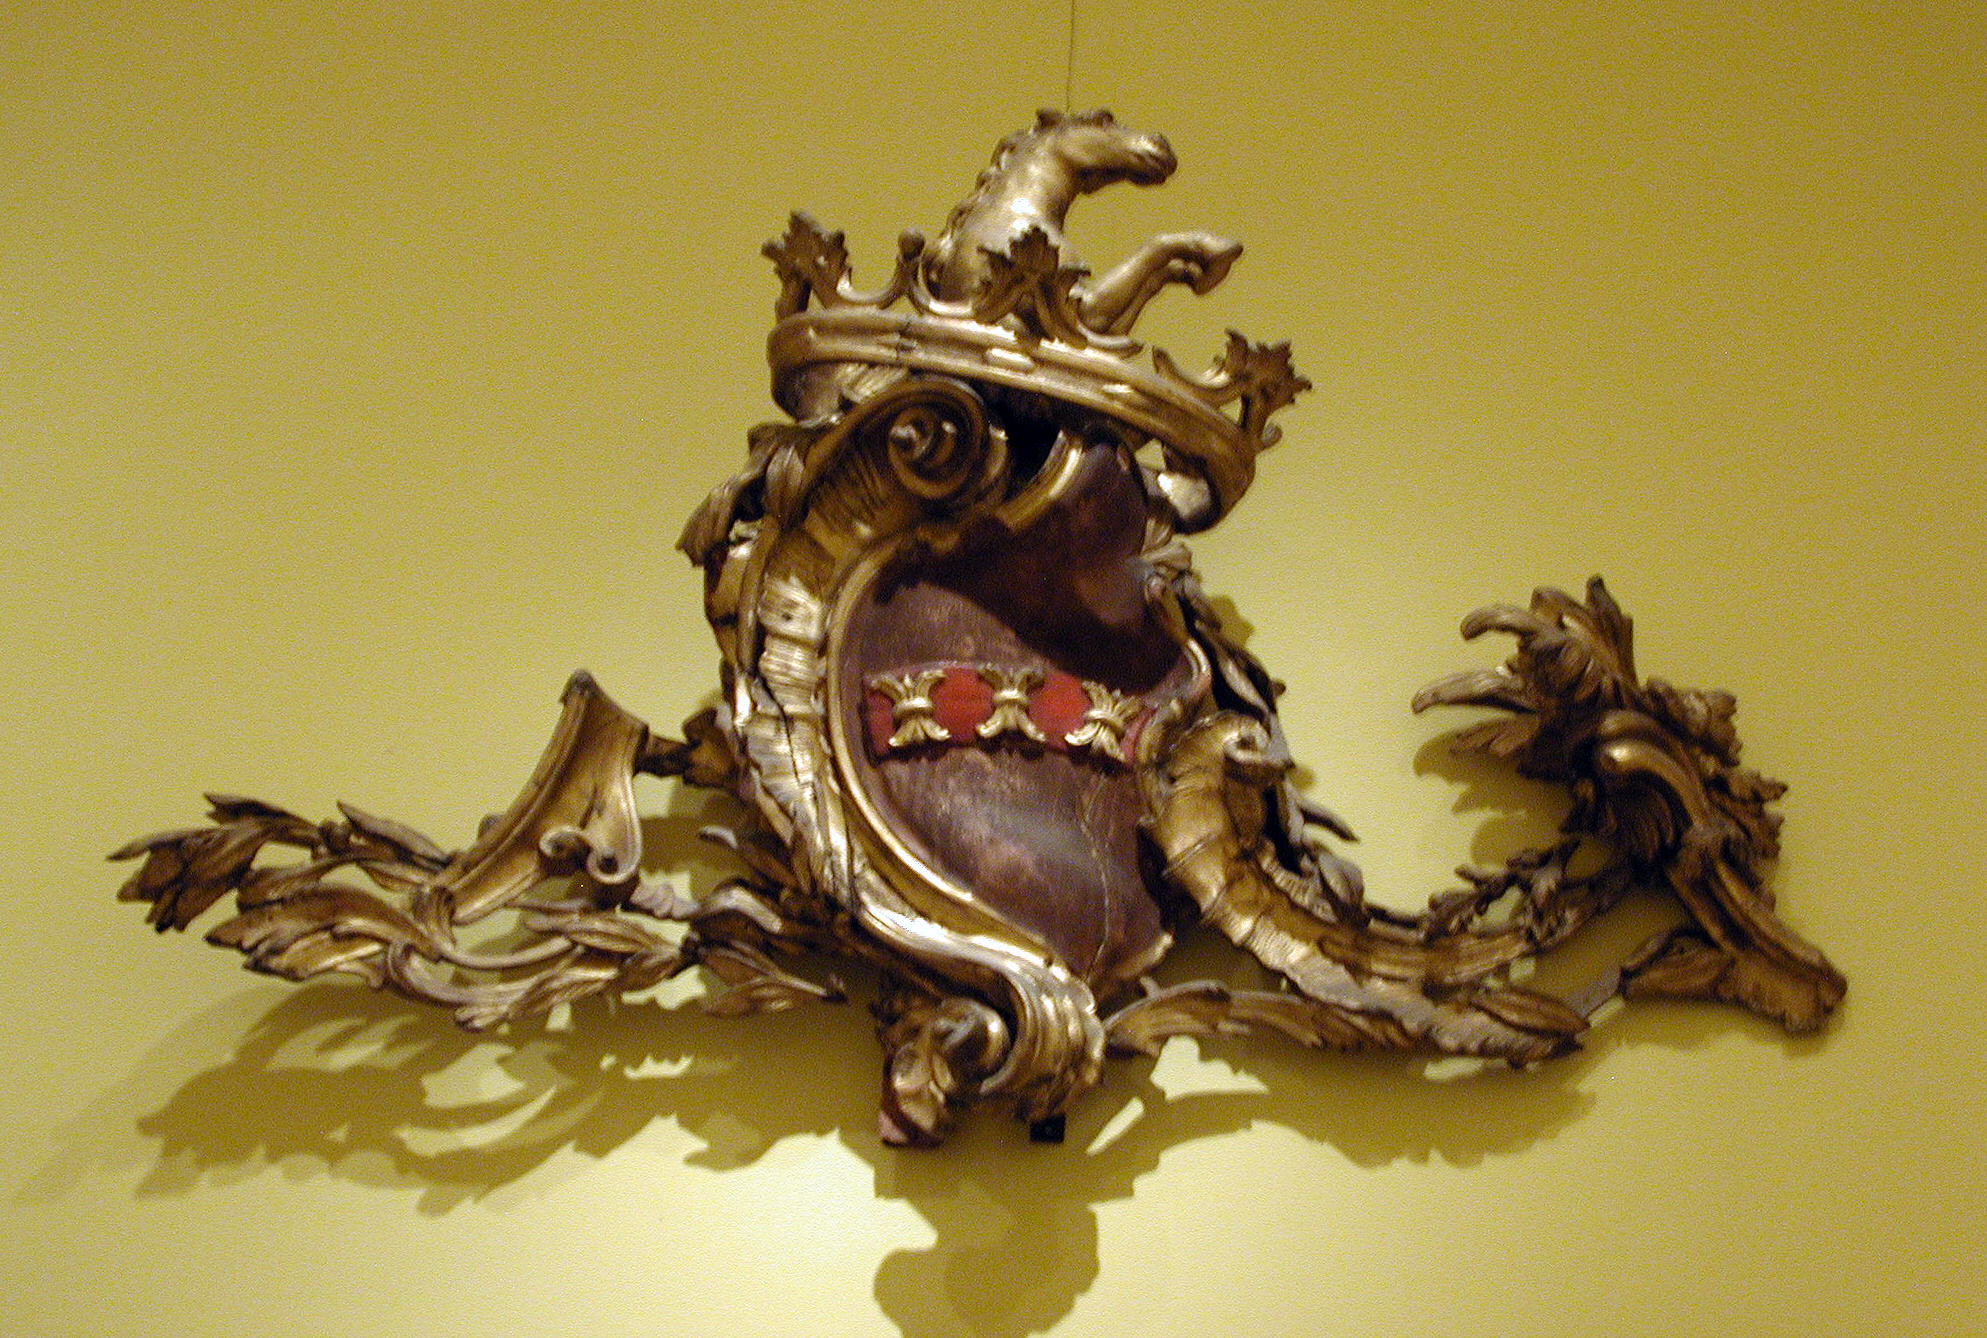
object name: frame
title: Overdoor cresting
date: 1701-1800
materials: wood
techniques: gilding, painting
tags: coat of arms